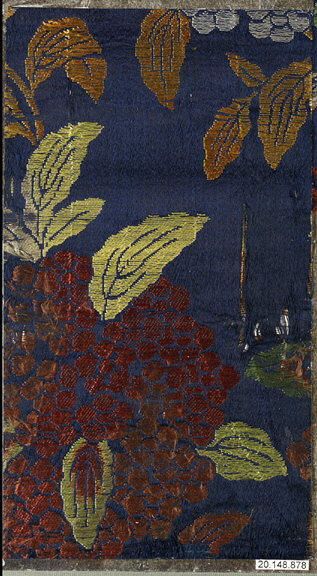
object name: piece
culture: chinese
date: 1601-1700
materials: silk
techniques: compound weave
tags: leaves